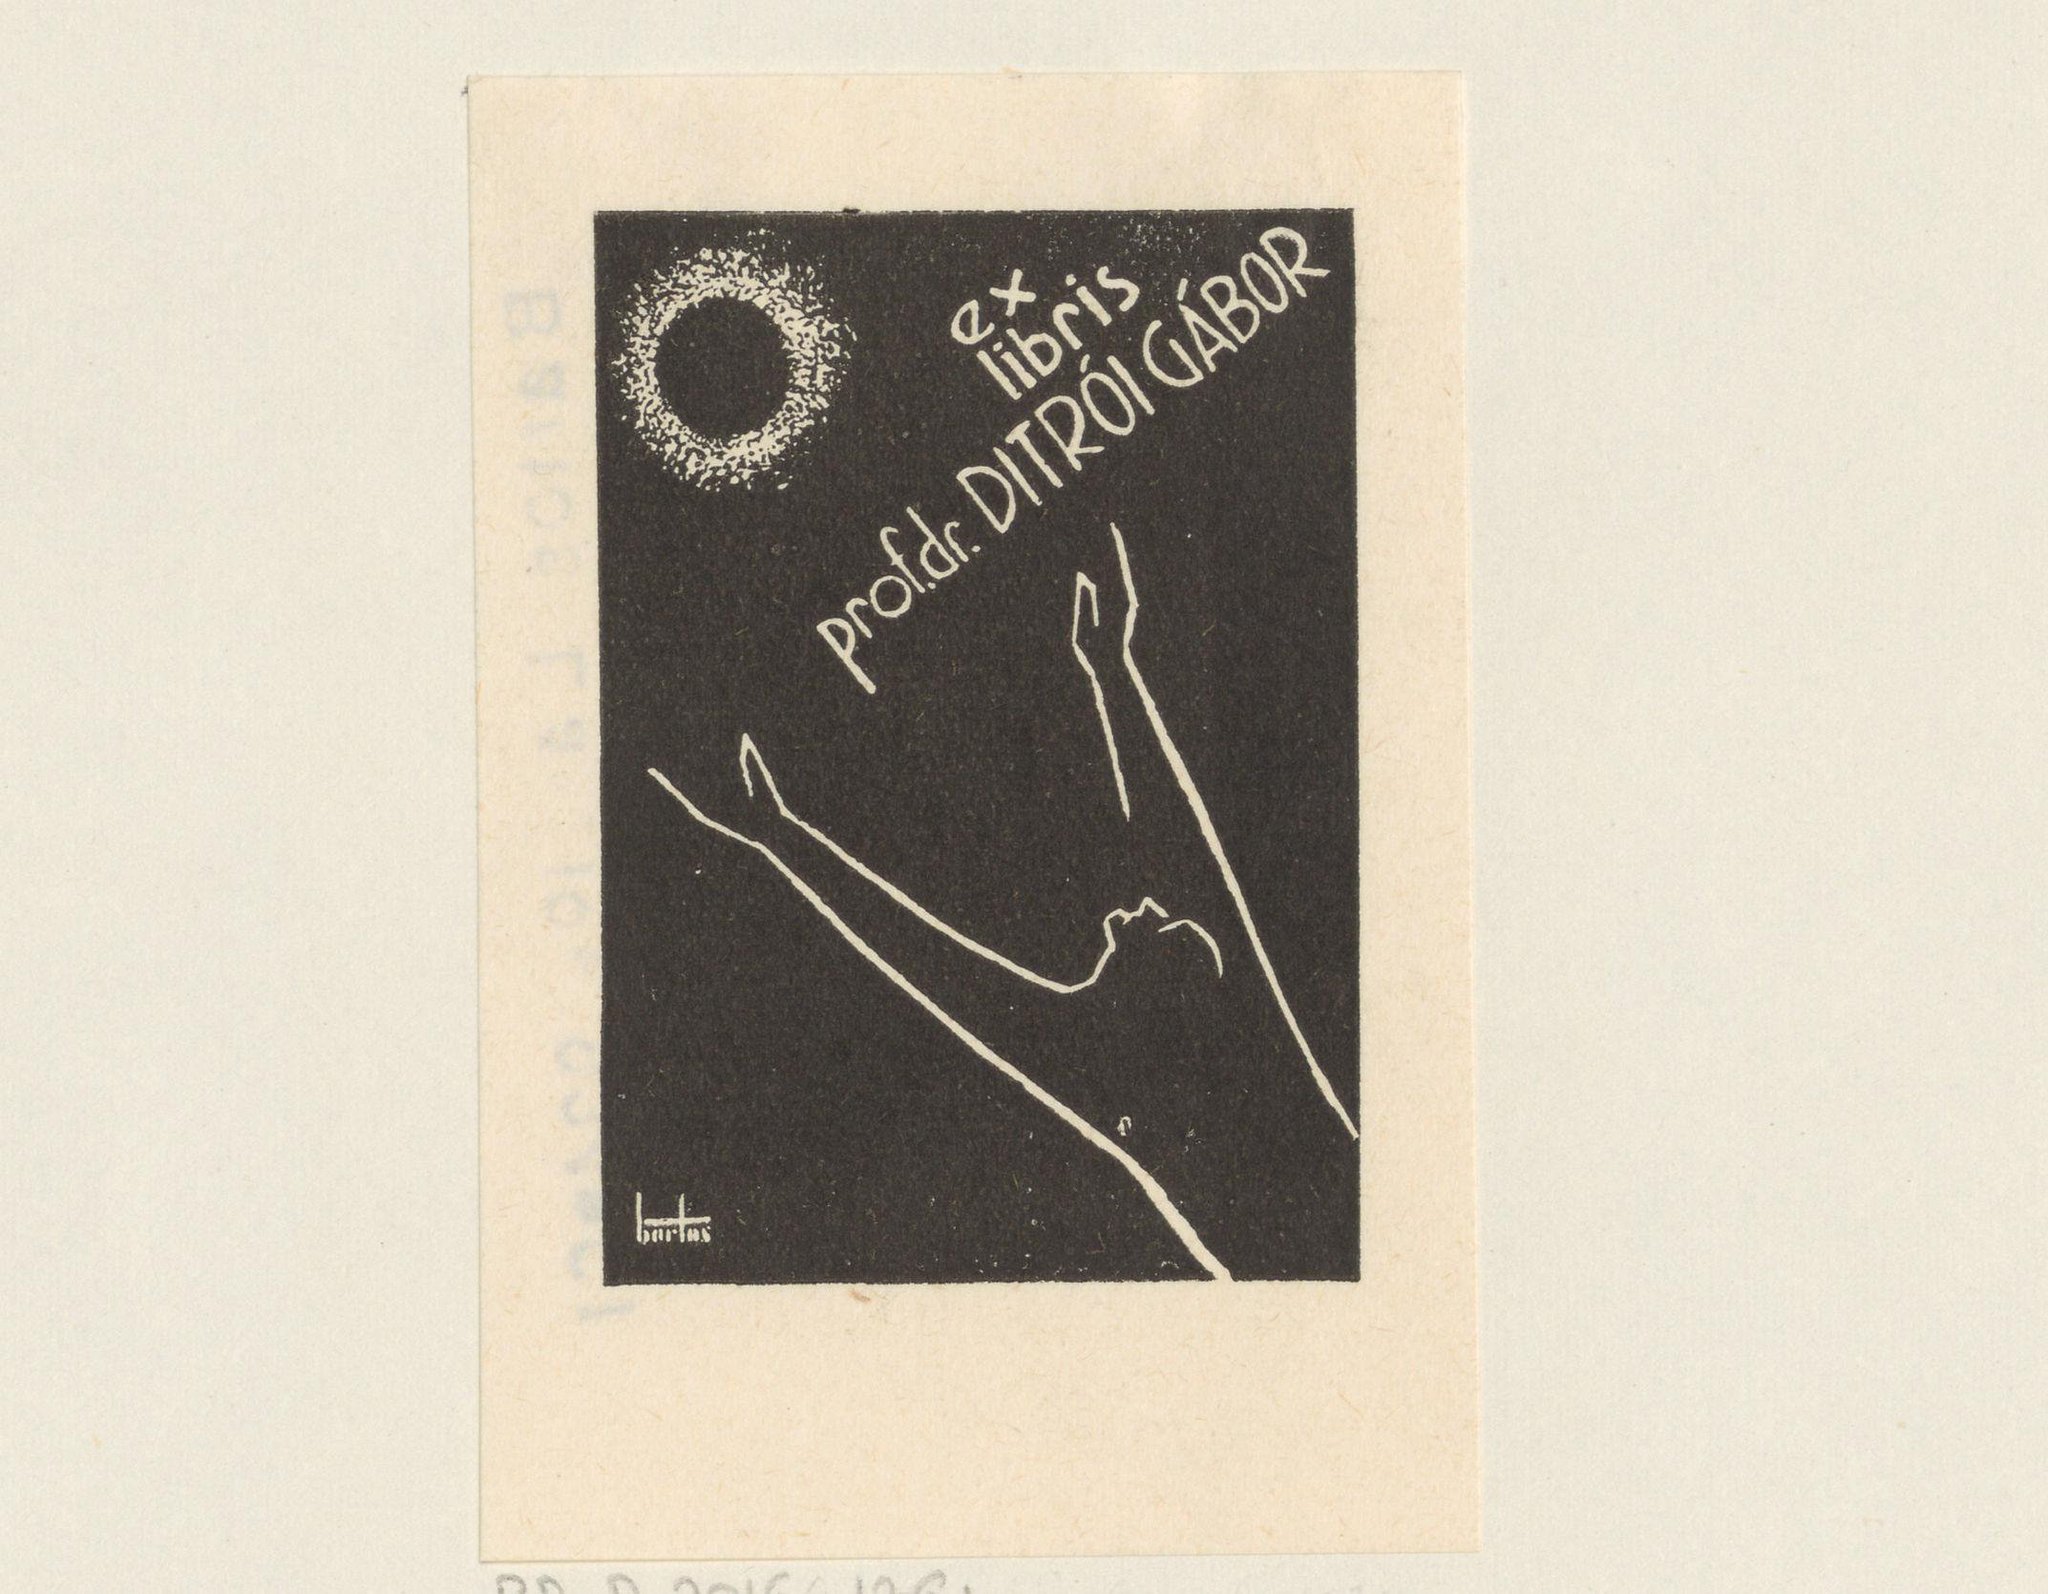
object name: bookplate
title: Ex libris van Ditrói Gábor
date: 1934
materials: paper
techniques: printing block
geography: hungary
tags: arm raised upward, solar eclipse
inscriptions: workshop stamp: ‘Bartos Lászlo.1934.Cl.’